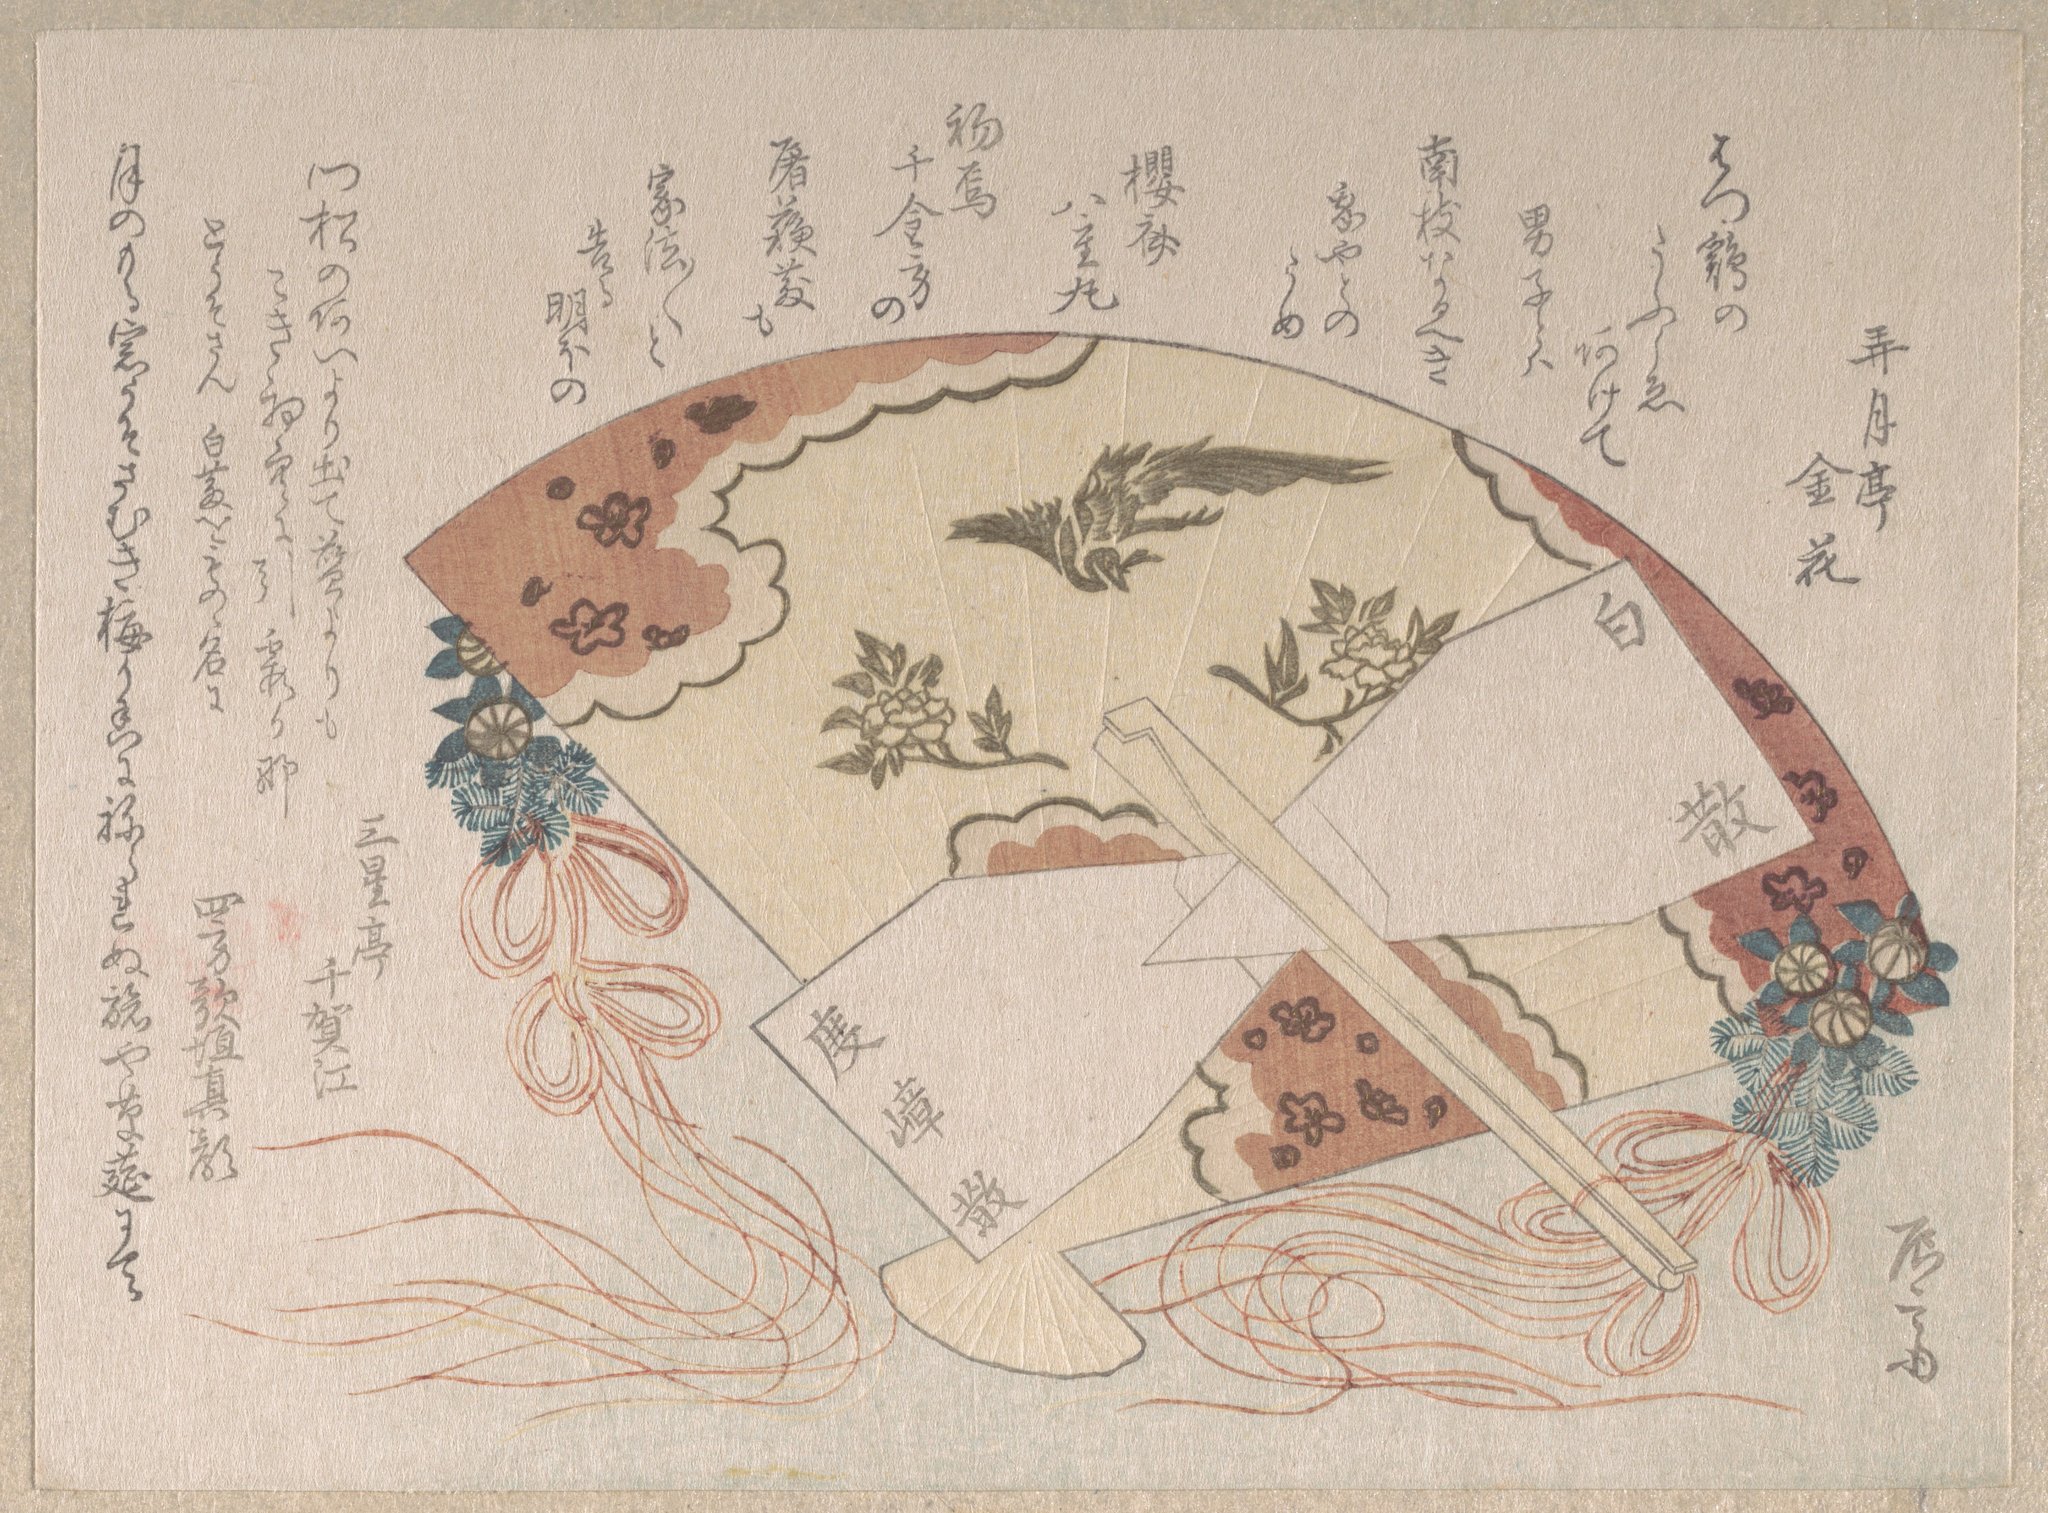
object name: print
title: Decorated Fan for the New Year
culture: japanese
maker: ryūryūkyo shinsai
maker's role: artist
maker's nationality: japanese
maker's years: 1799-1823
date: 1801-1900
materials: ink, paper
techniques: surimono, woodblock print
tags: birds,fans